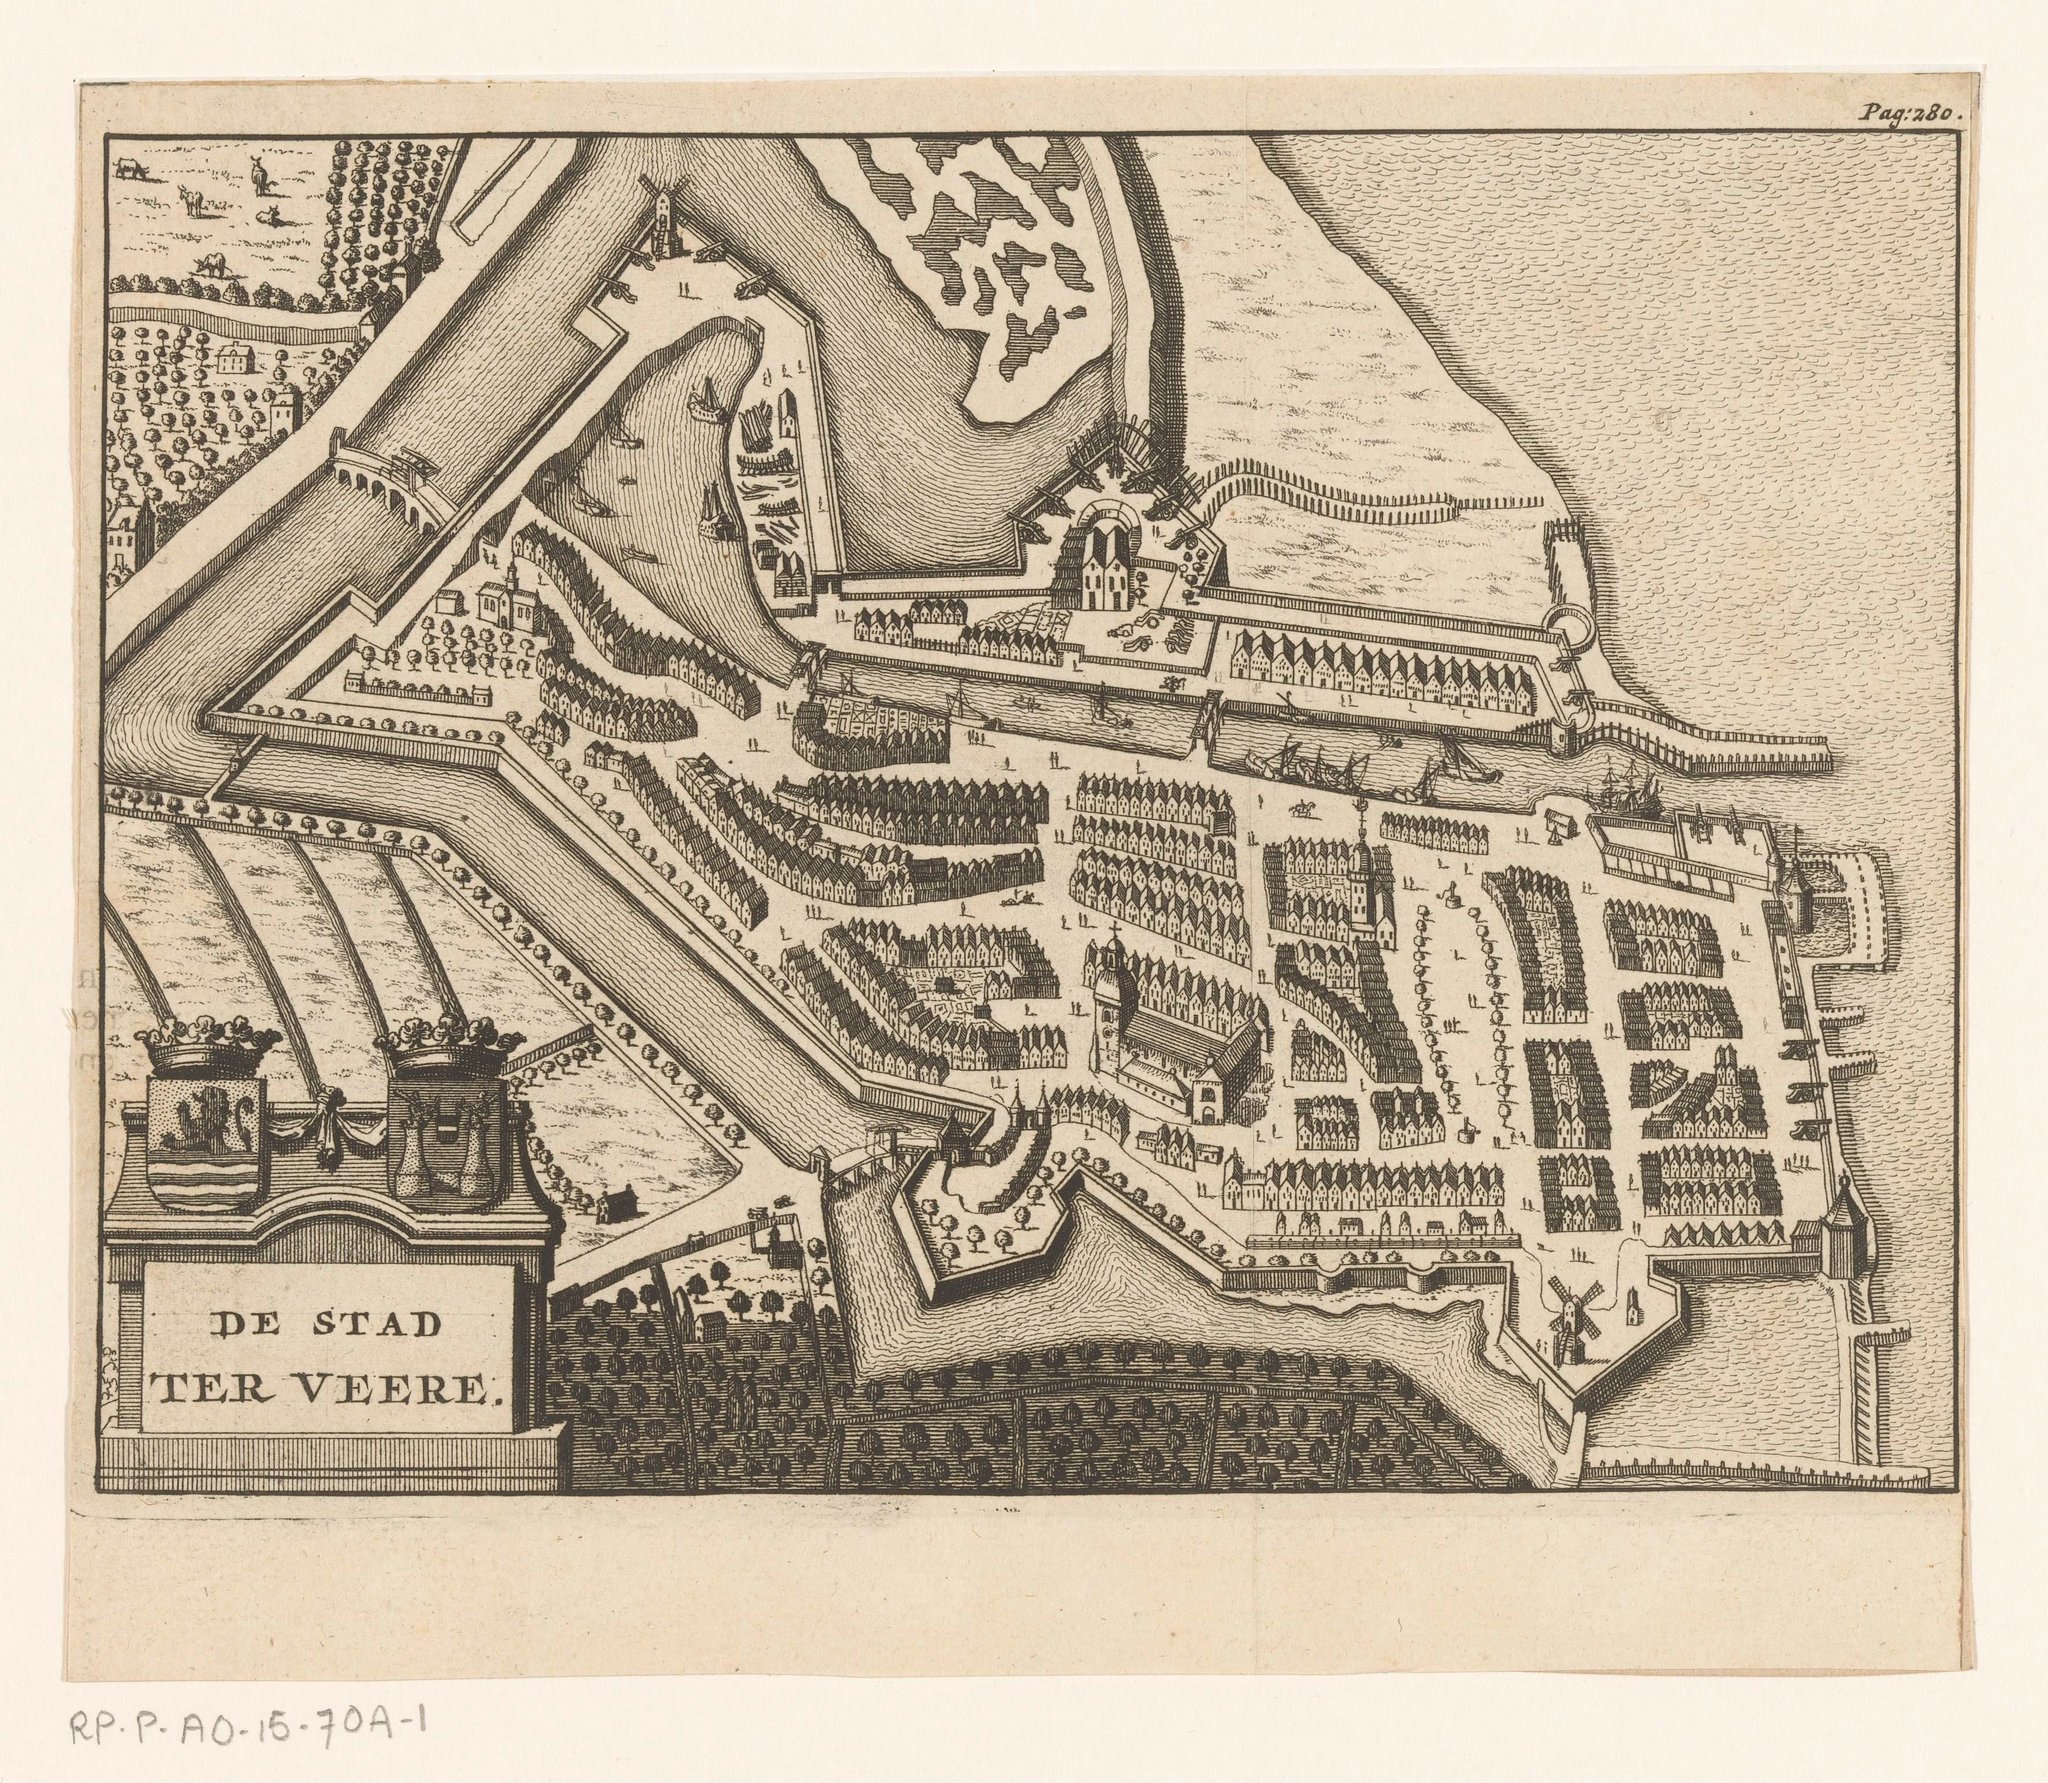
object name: book illustration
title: De stad Ter Veere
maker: Anonymous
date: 1715-1755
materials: paper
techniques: etching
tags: coat of arms (as symbol of the state, etc.) (+ city; municipal), maps of cities, coat of arms (as symbol of the state, etc.) (+ province; provincial)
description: Prent ook gebruikt in: Gargon, Mattheus. Walchersche arkadia, waar in op een zoetvoerigen trant (…). 2 delen. Leiden: Samuel Luchtmans, 1715-1717, dl. 1 (1715), p. 280. En in: Gargon, Mattheus. Walchersche arkadia, waar in op een zoetvoerigen trant (…). 2 delen. Leiden: Samuel Luchtmans en Zoon, 1746, dl. 1, p. 280. En in: Gargon, Mattheus. Walchersche arkadia, waar in op een zoetvoerigen trant (…). 2 delen. Middelburg: M.H. en A.L. Callenfels, S. Mandelgreen, P. Gillissen en L. Taillefert, 1755, dl. 1, p. 280.